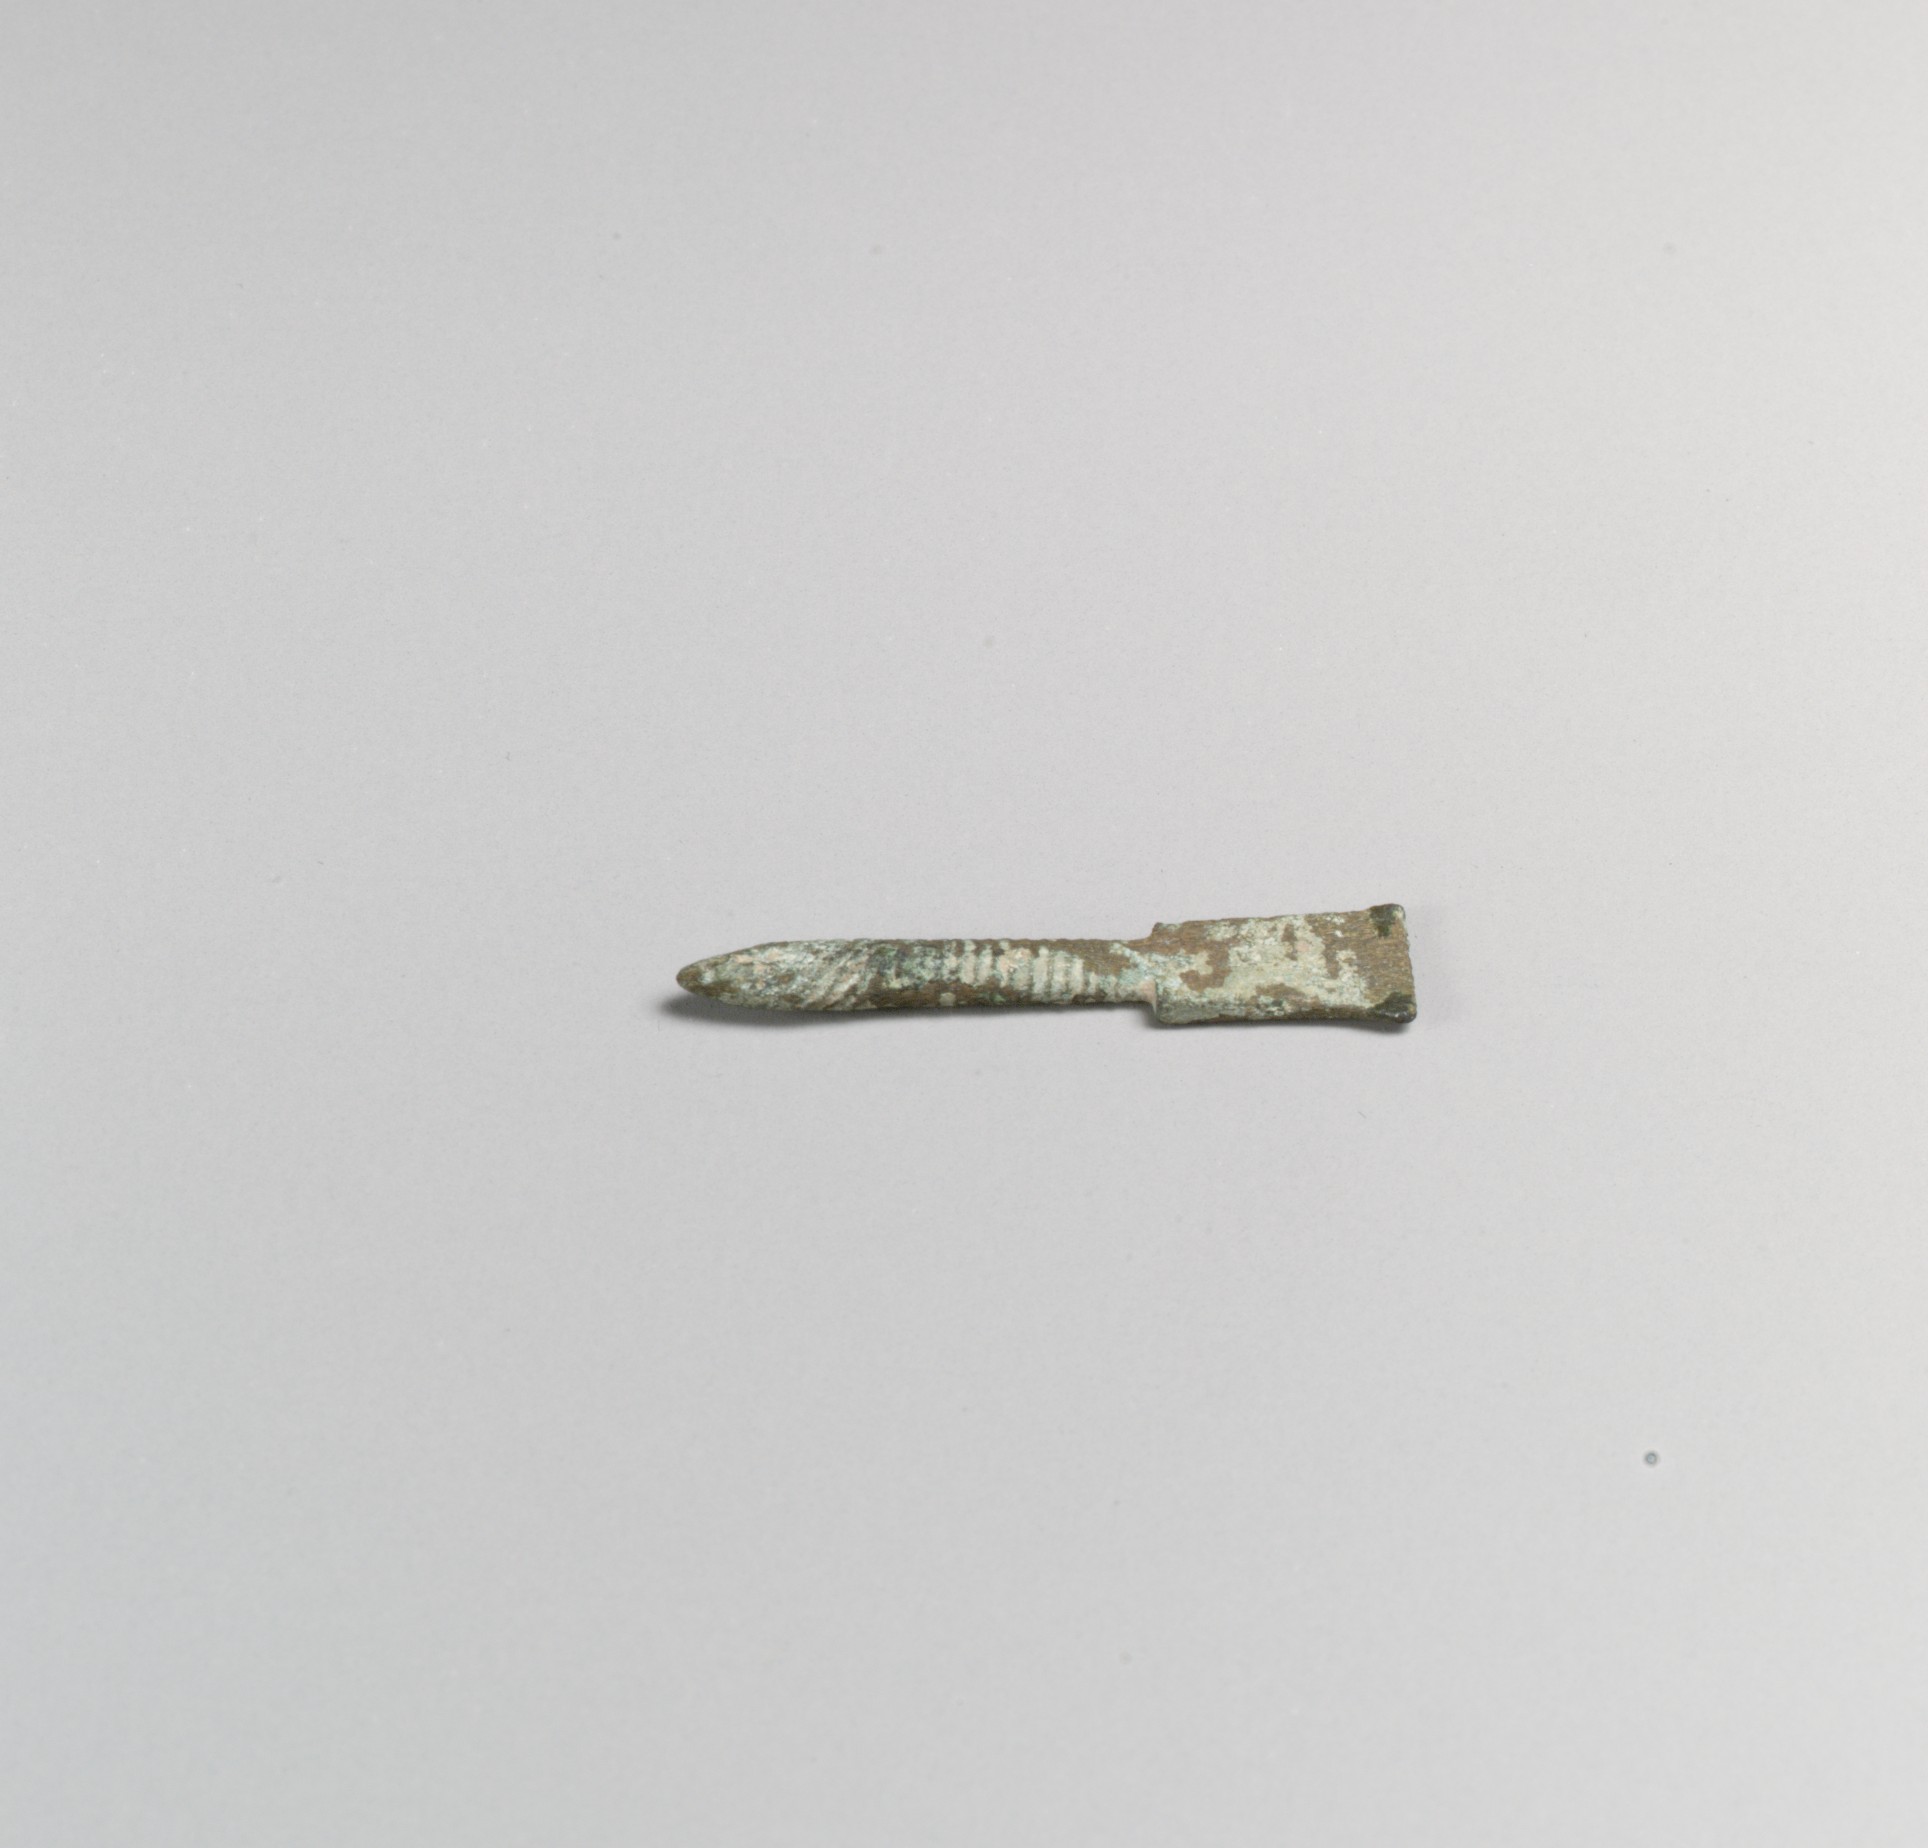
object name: chisel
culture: roman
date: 670 BCE-330 CE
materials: bone, bronze